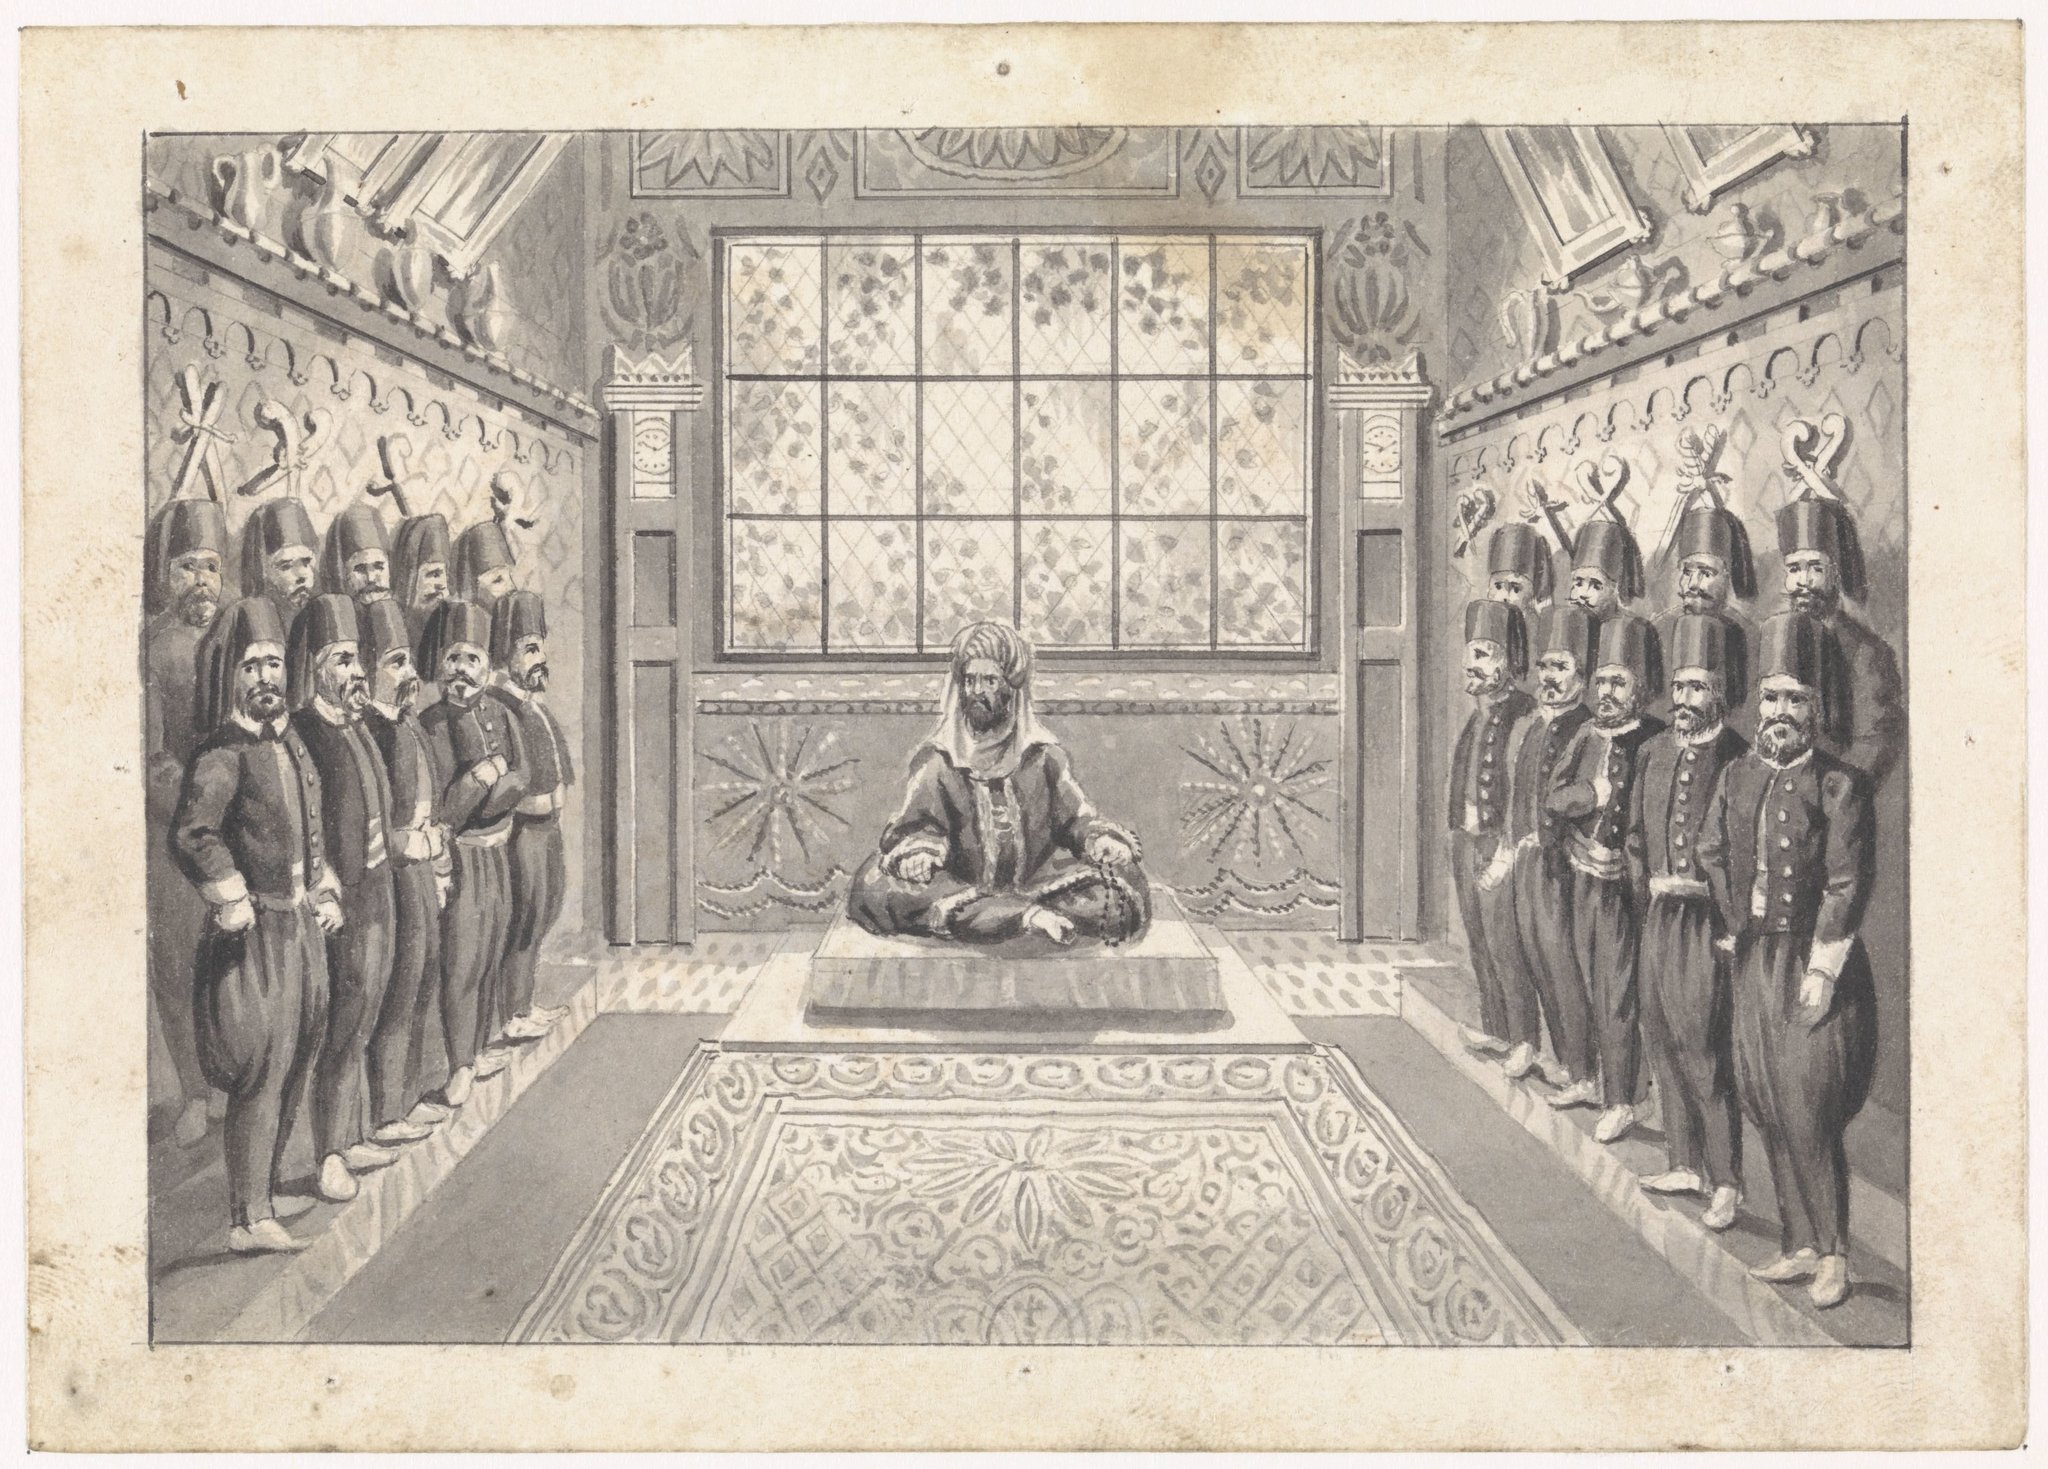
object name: design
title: Turkse vorst met zijn wacht in een zaal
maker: Anonymous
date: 1800-1900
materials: ink, paper, pencil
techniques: brush, pen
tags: asiatic races and peoples, ruler, sovereign